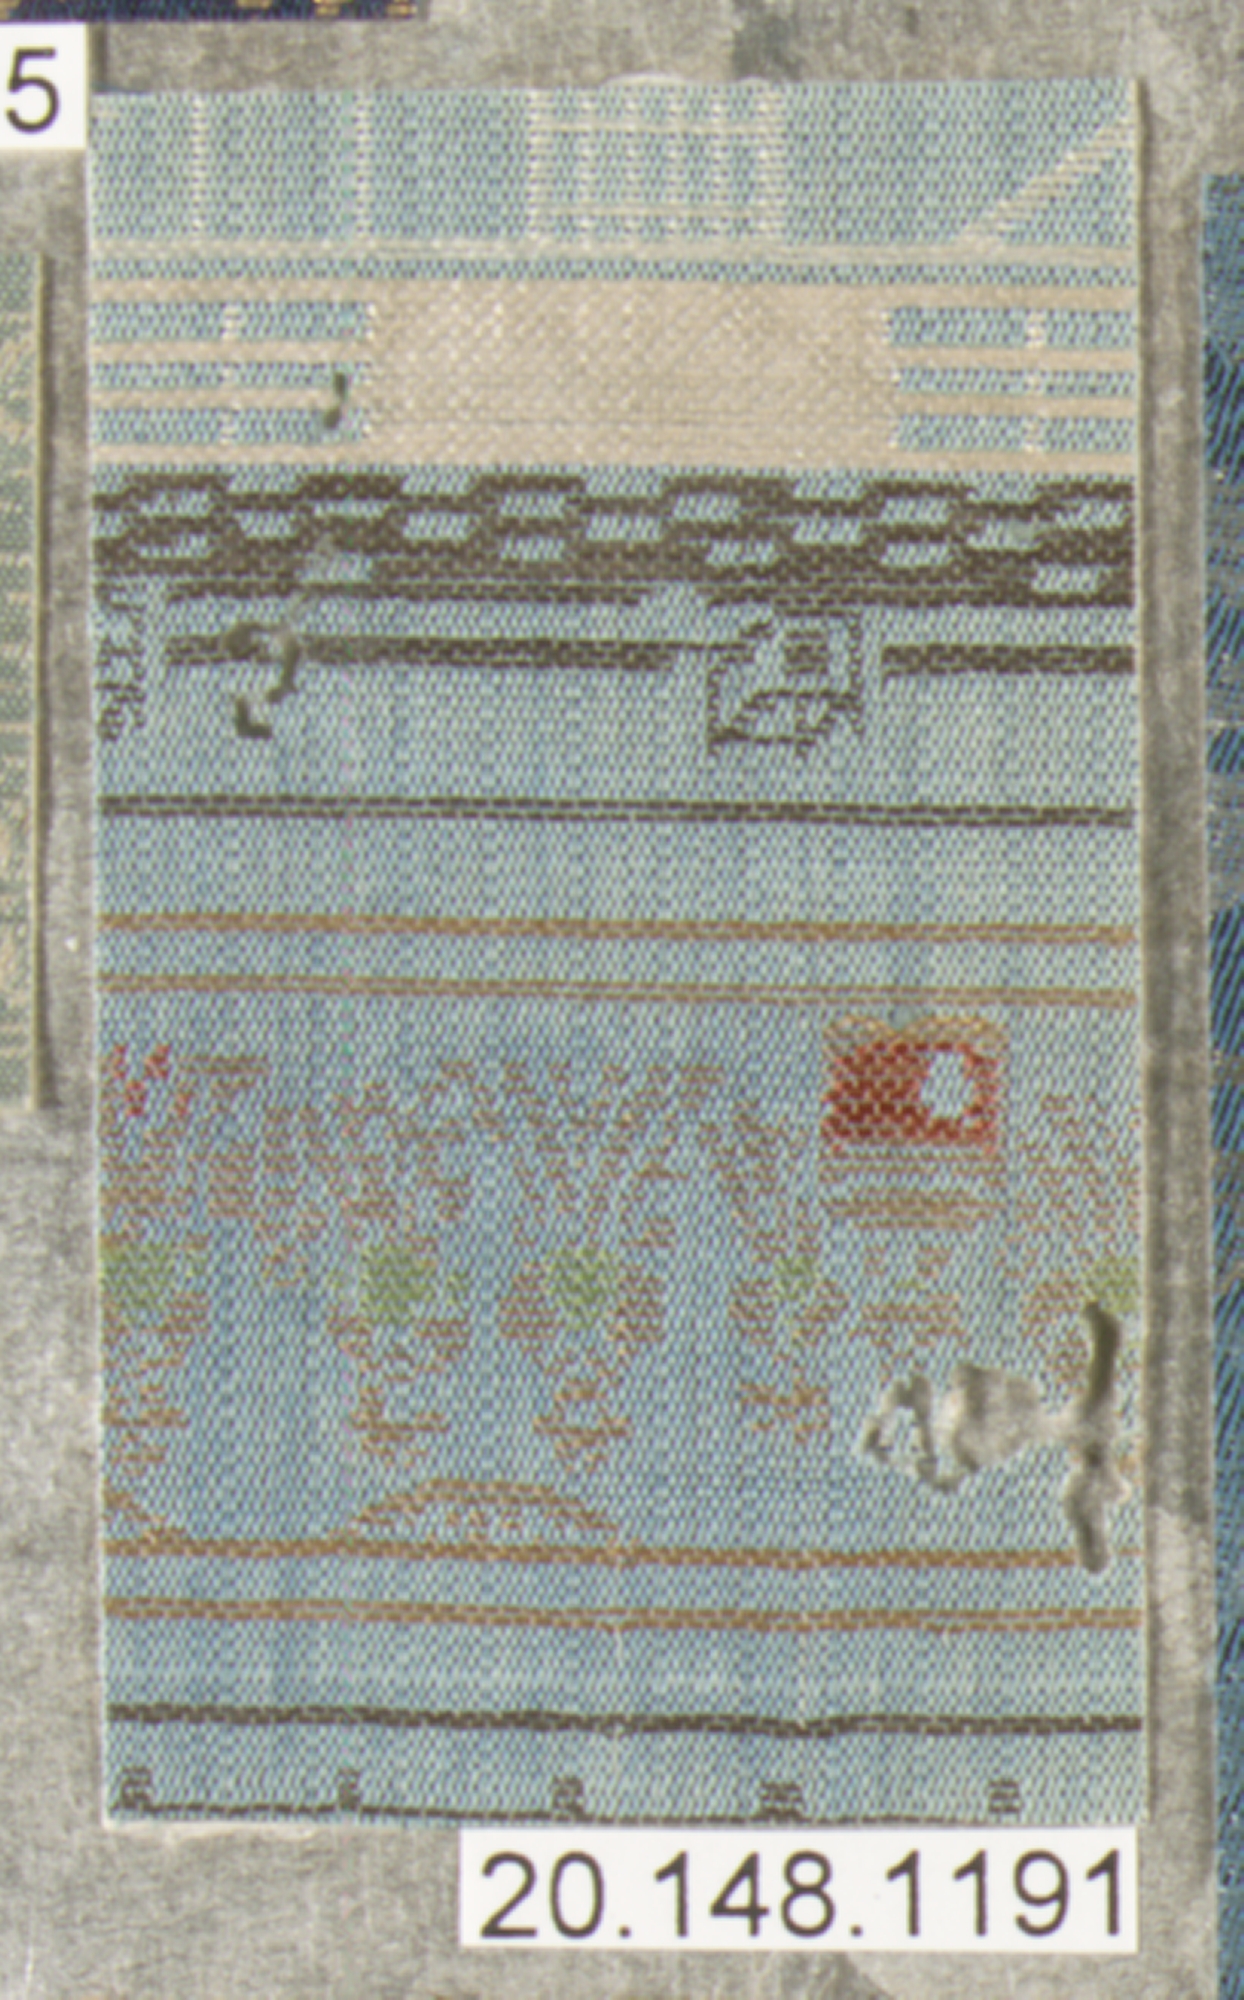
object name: piece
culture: japanese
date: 1701-1800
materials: silk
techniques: compound weave